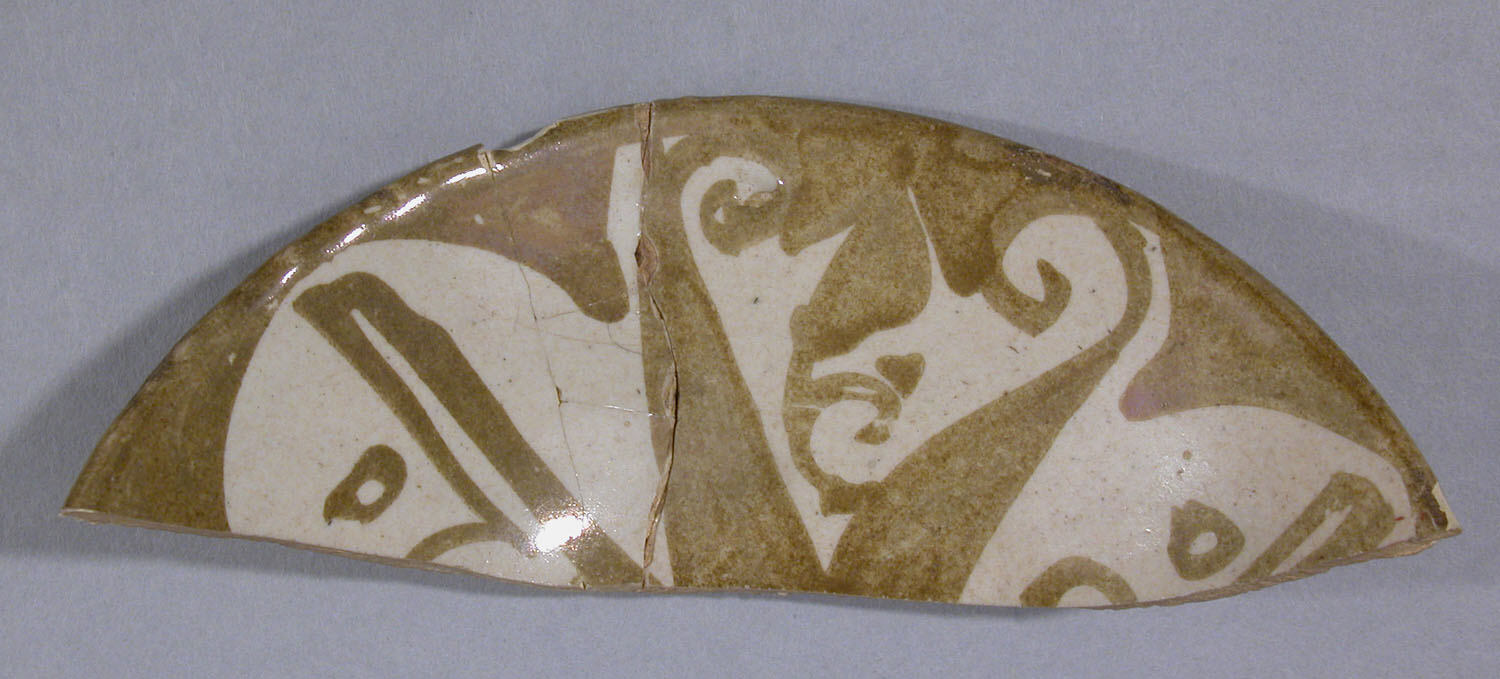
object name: fragment of a bowl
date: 801-900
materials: earthenware, glaze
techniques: luster painting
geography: iraq